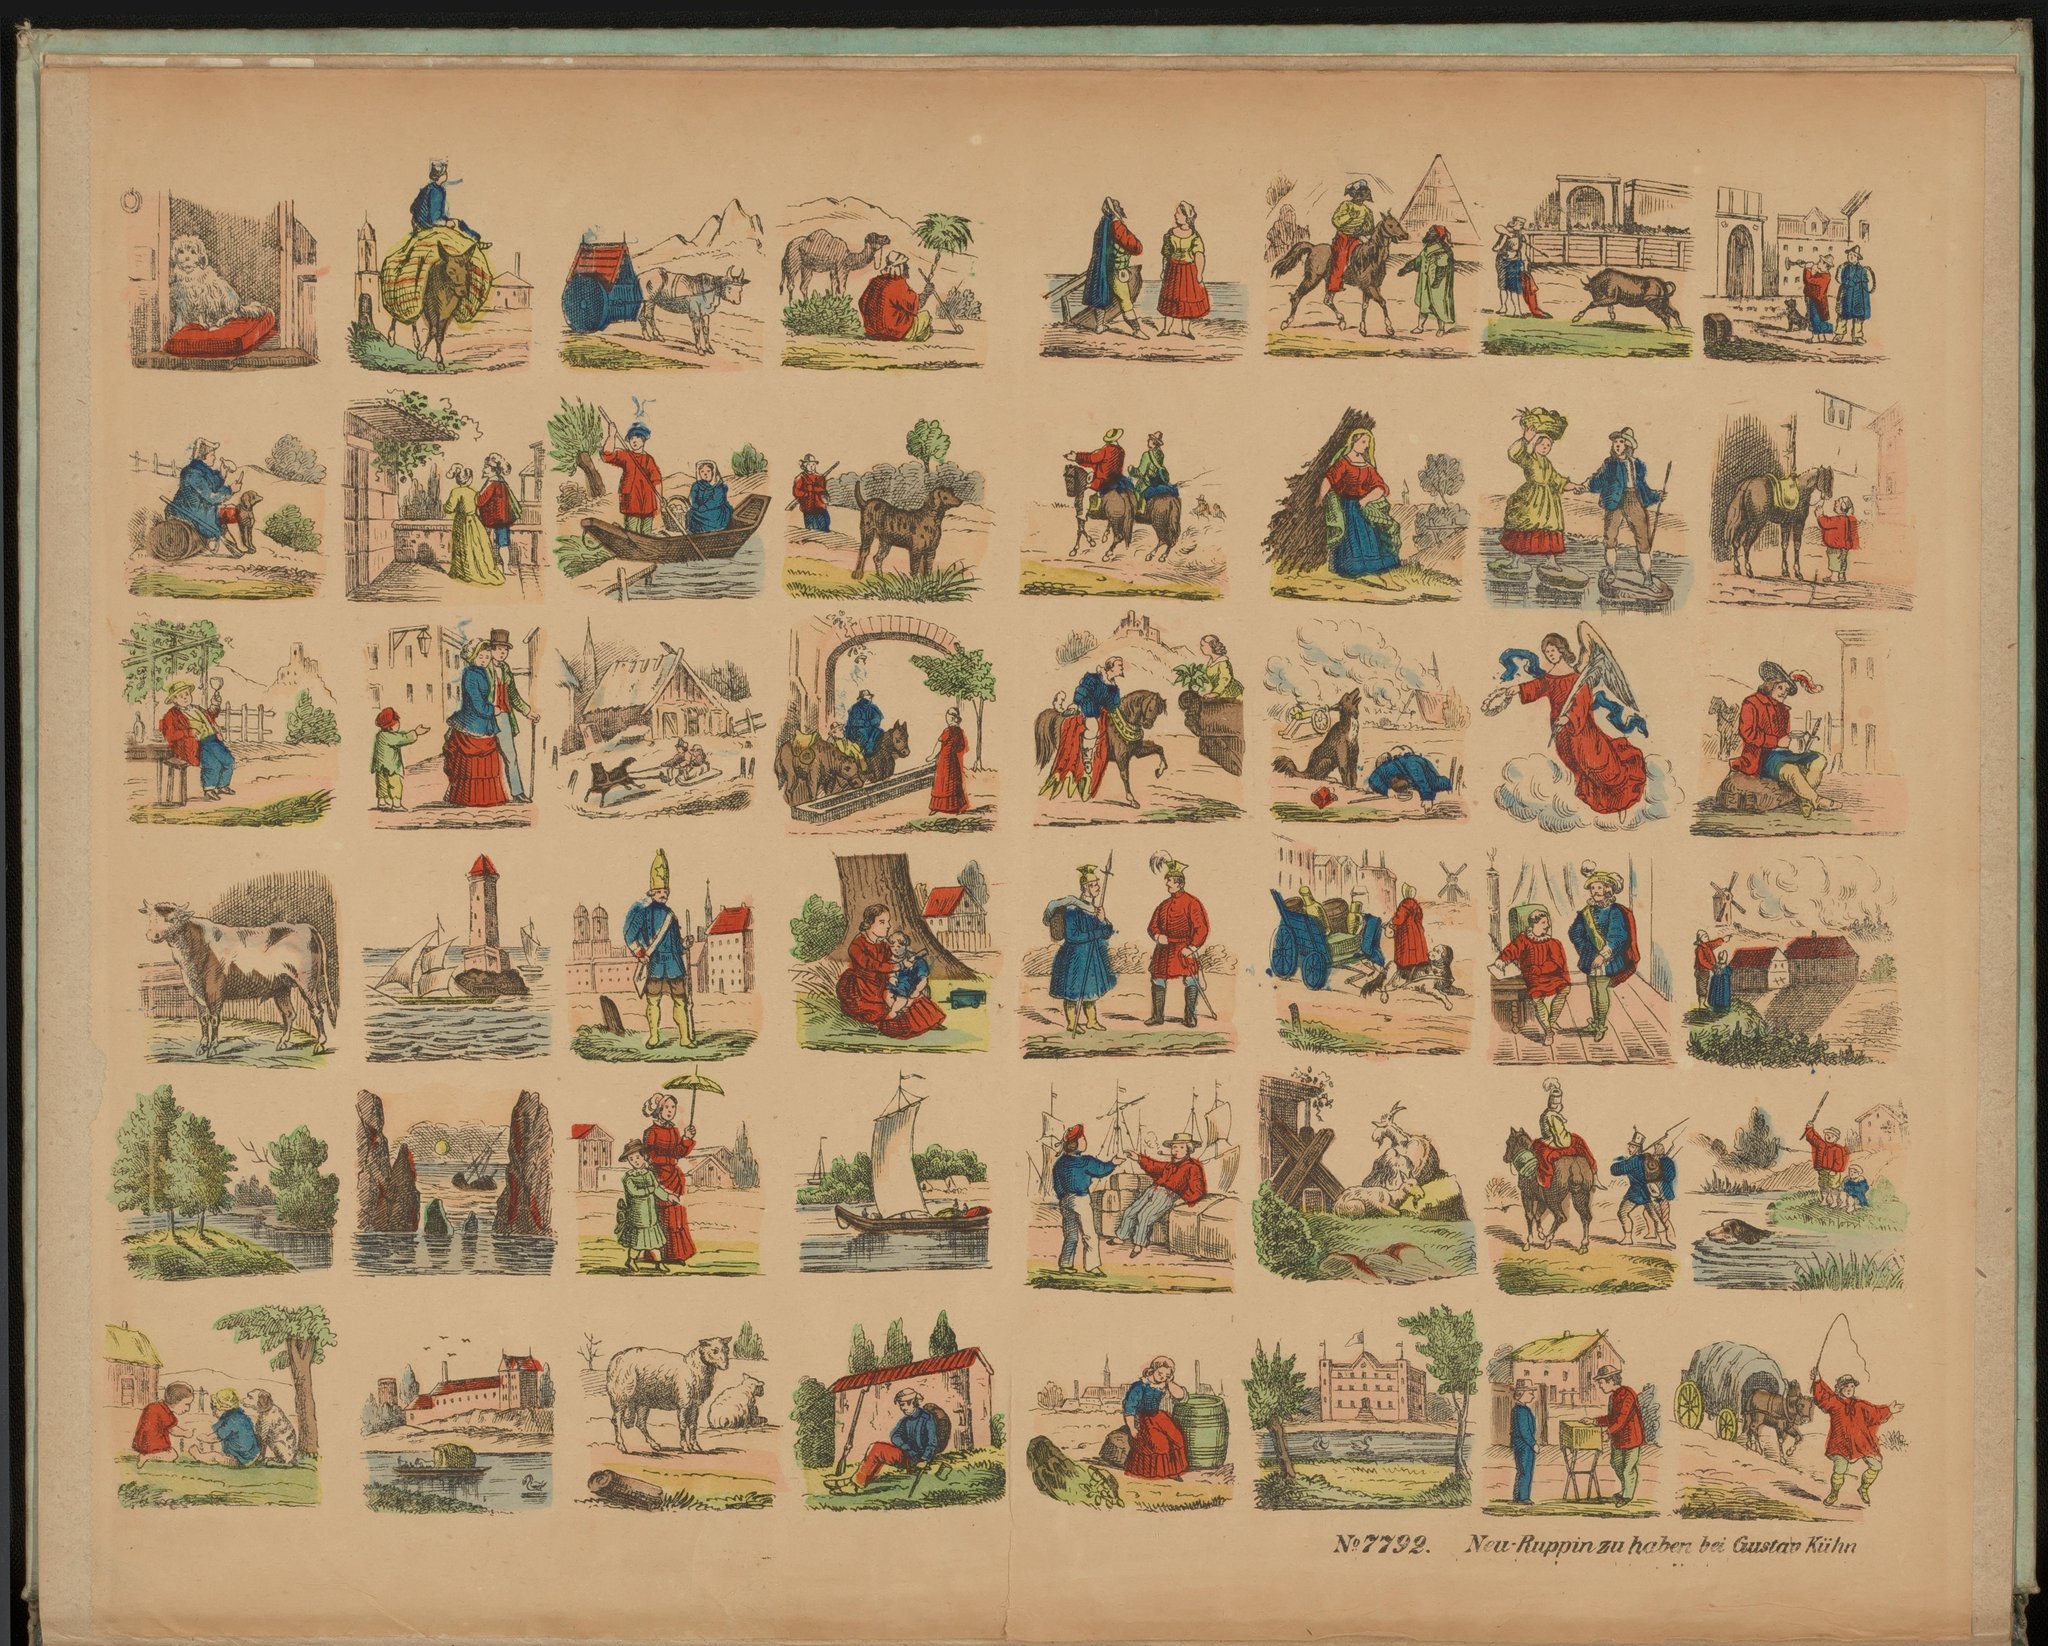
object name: print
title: Activiteiten van mensen en dieren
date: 1825-1868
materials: paper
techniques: hand coloring, lithograph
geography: neuruppin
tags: lighthouse, lightship, riding a horse, ass, or mule; rider, horseman, hoofed animals: camel, ass, donkey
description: Vijf rijen met zeven kleine voorstellingen van activiteiten van mensen en dieren, zoals wijn drinken en stierenvechten. Rechtsonder genummerd: No. 7792. Onderwerpsrubrieken binnen de Atlas Zeden en Gewoonten: Zeden en gewoonten in engeren zin, Des menschen begin, midden en einde.